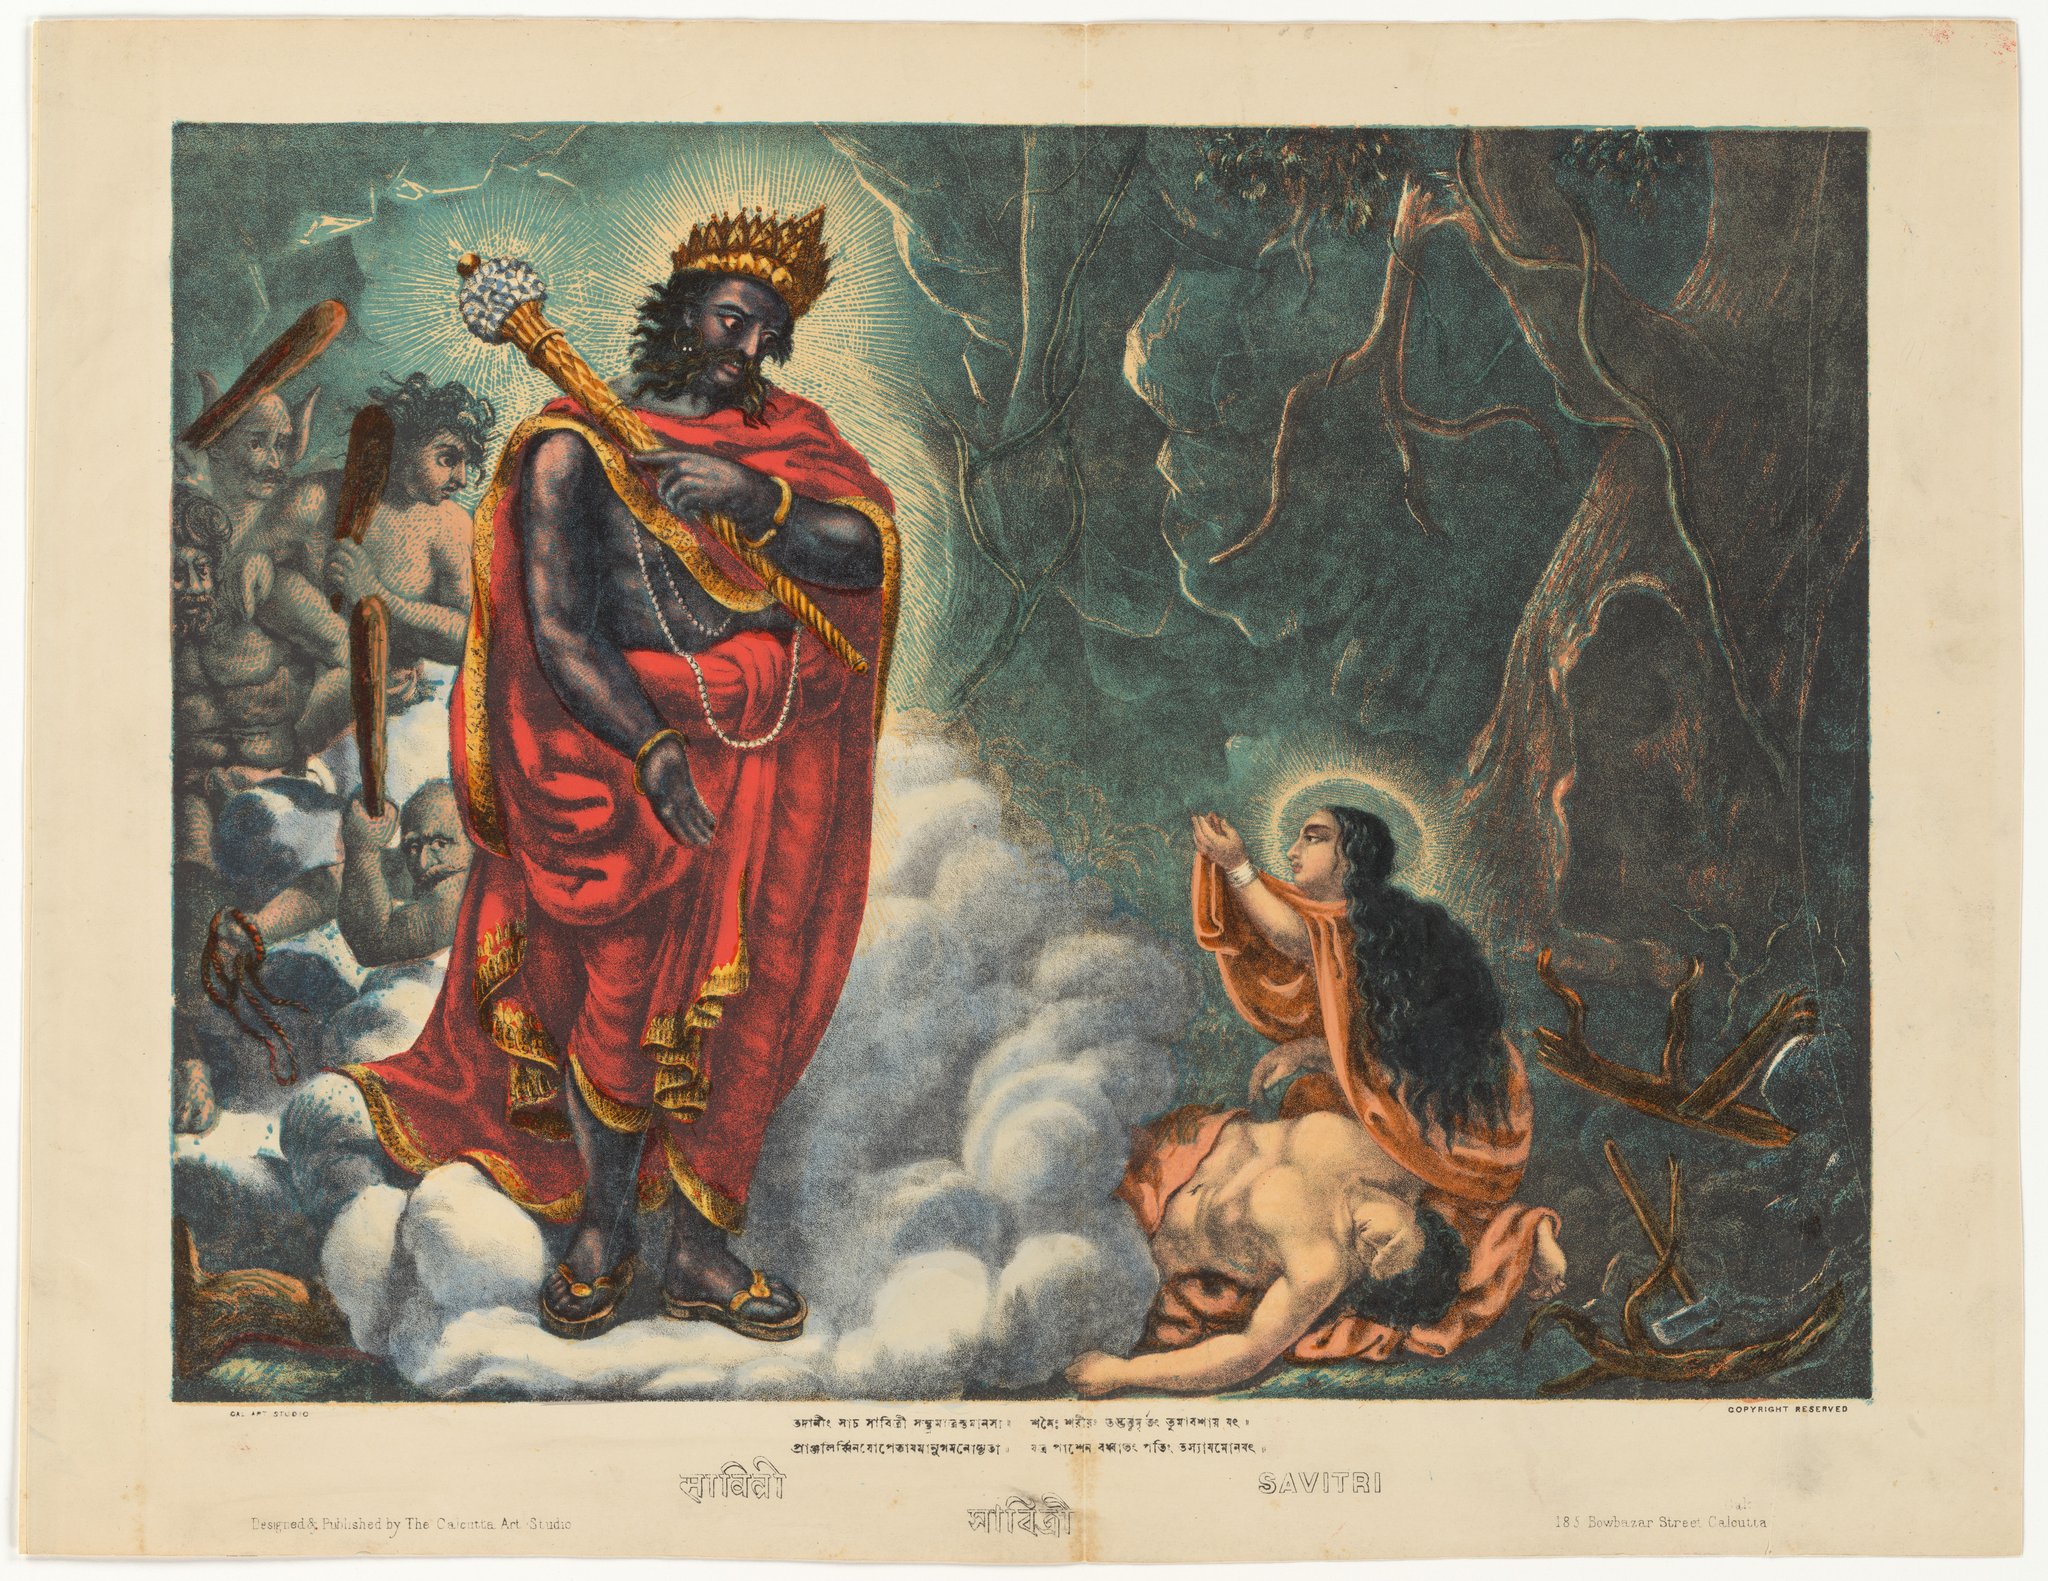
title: Savitri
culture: west bengali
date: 1878-1883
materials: glaze, watercolor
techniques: hand coloring, lithograph, printing